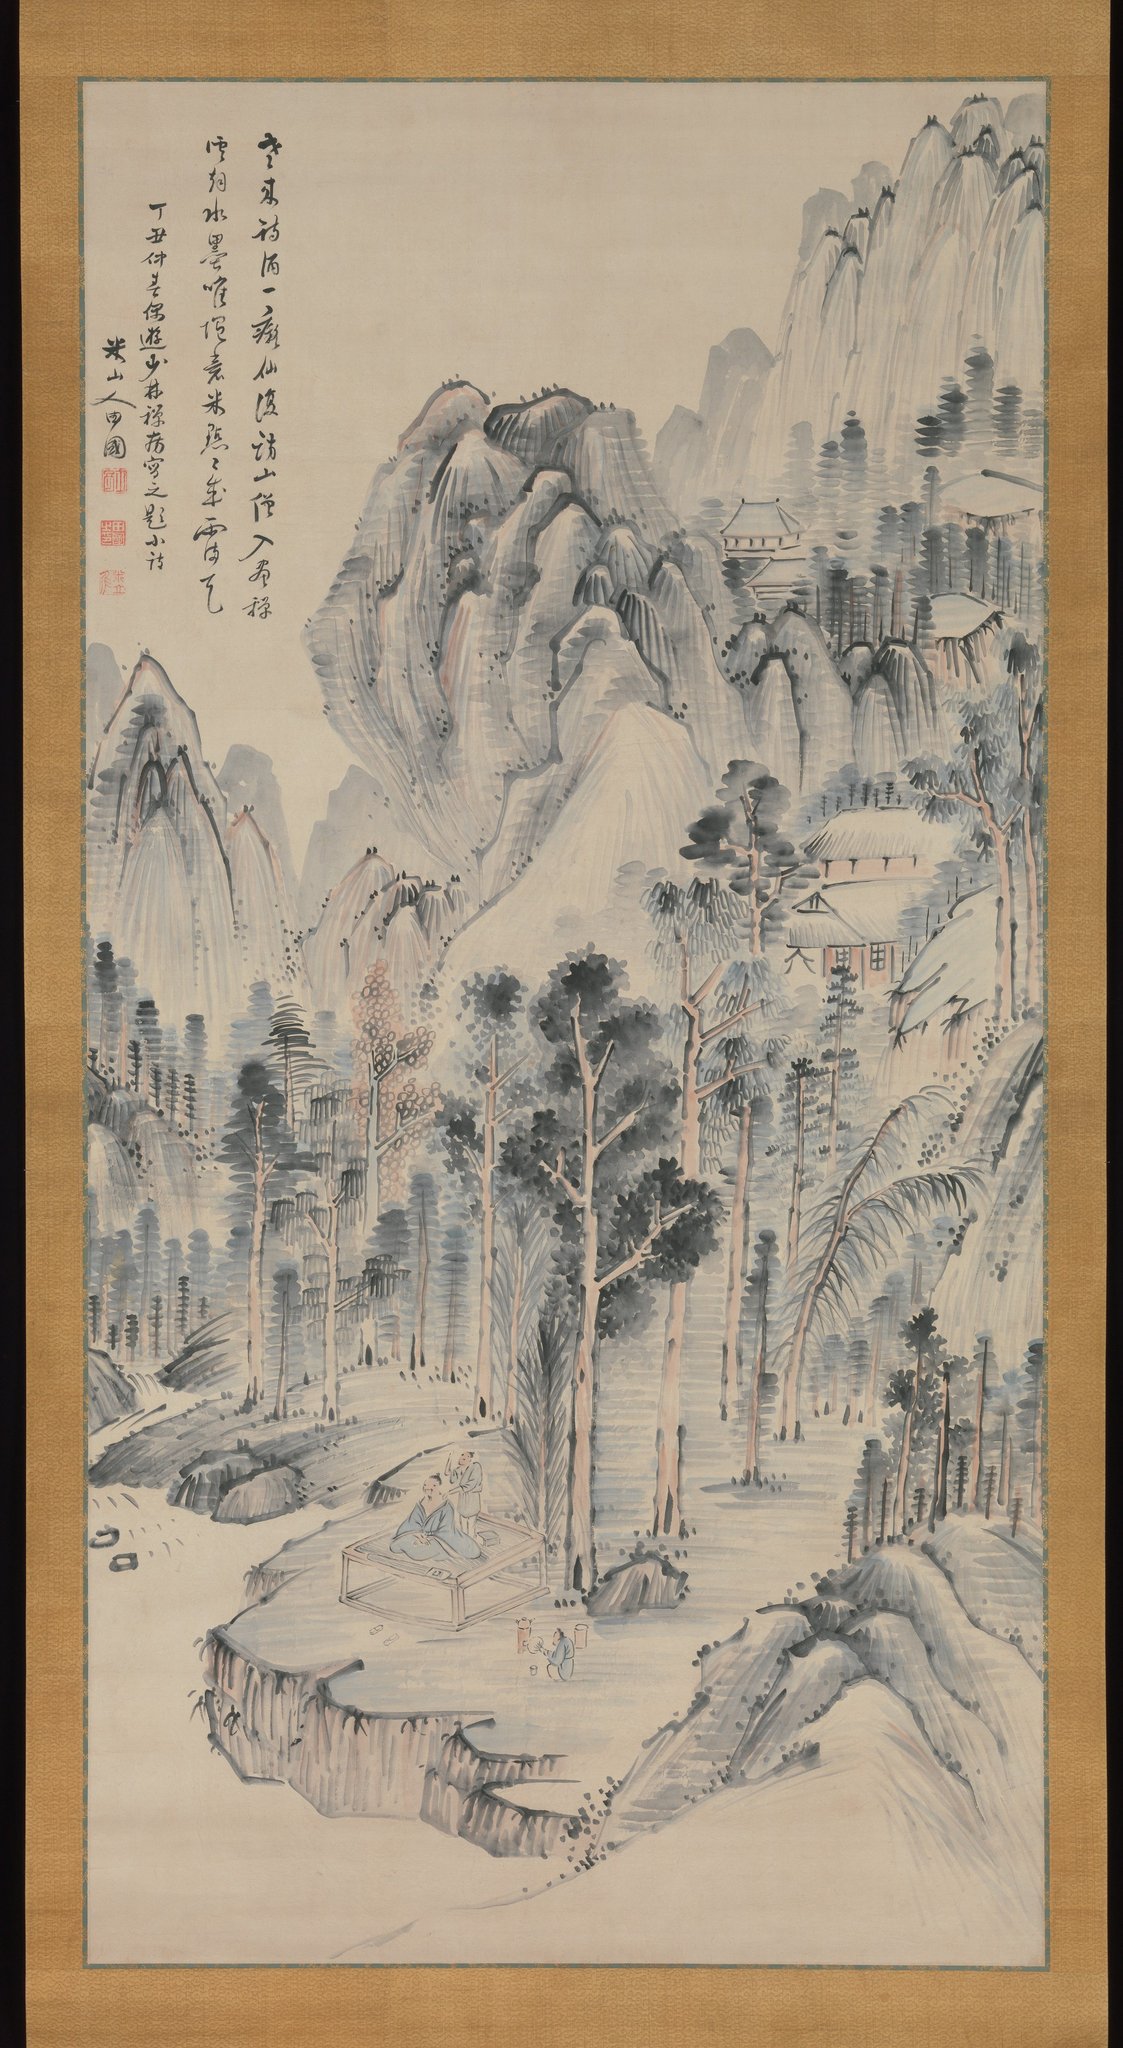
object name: hanging scroll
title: Shōrinji Temple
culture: japanese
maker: okada beisanjin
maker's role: artist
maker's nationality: japanese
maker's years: 1744-1820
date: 1817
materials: ink, paper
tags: mountains,landscapes